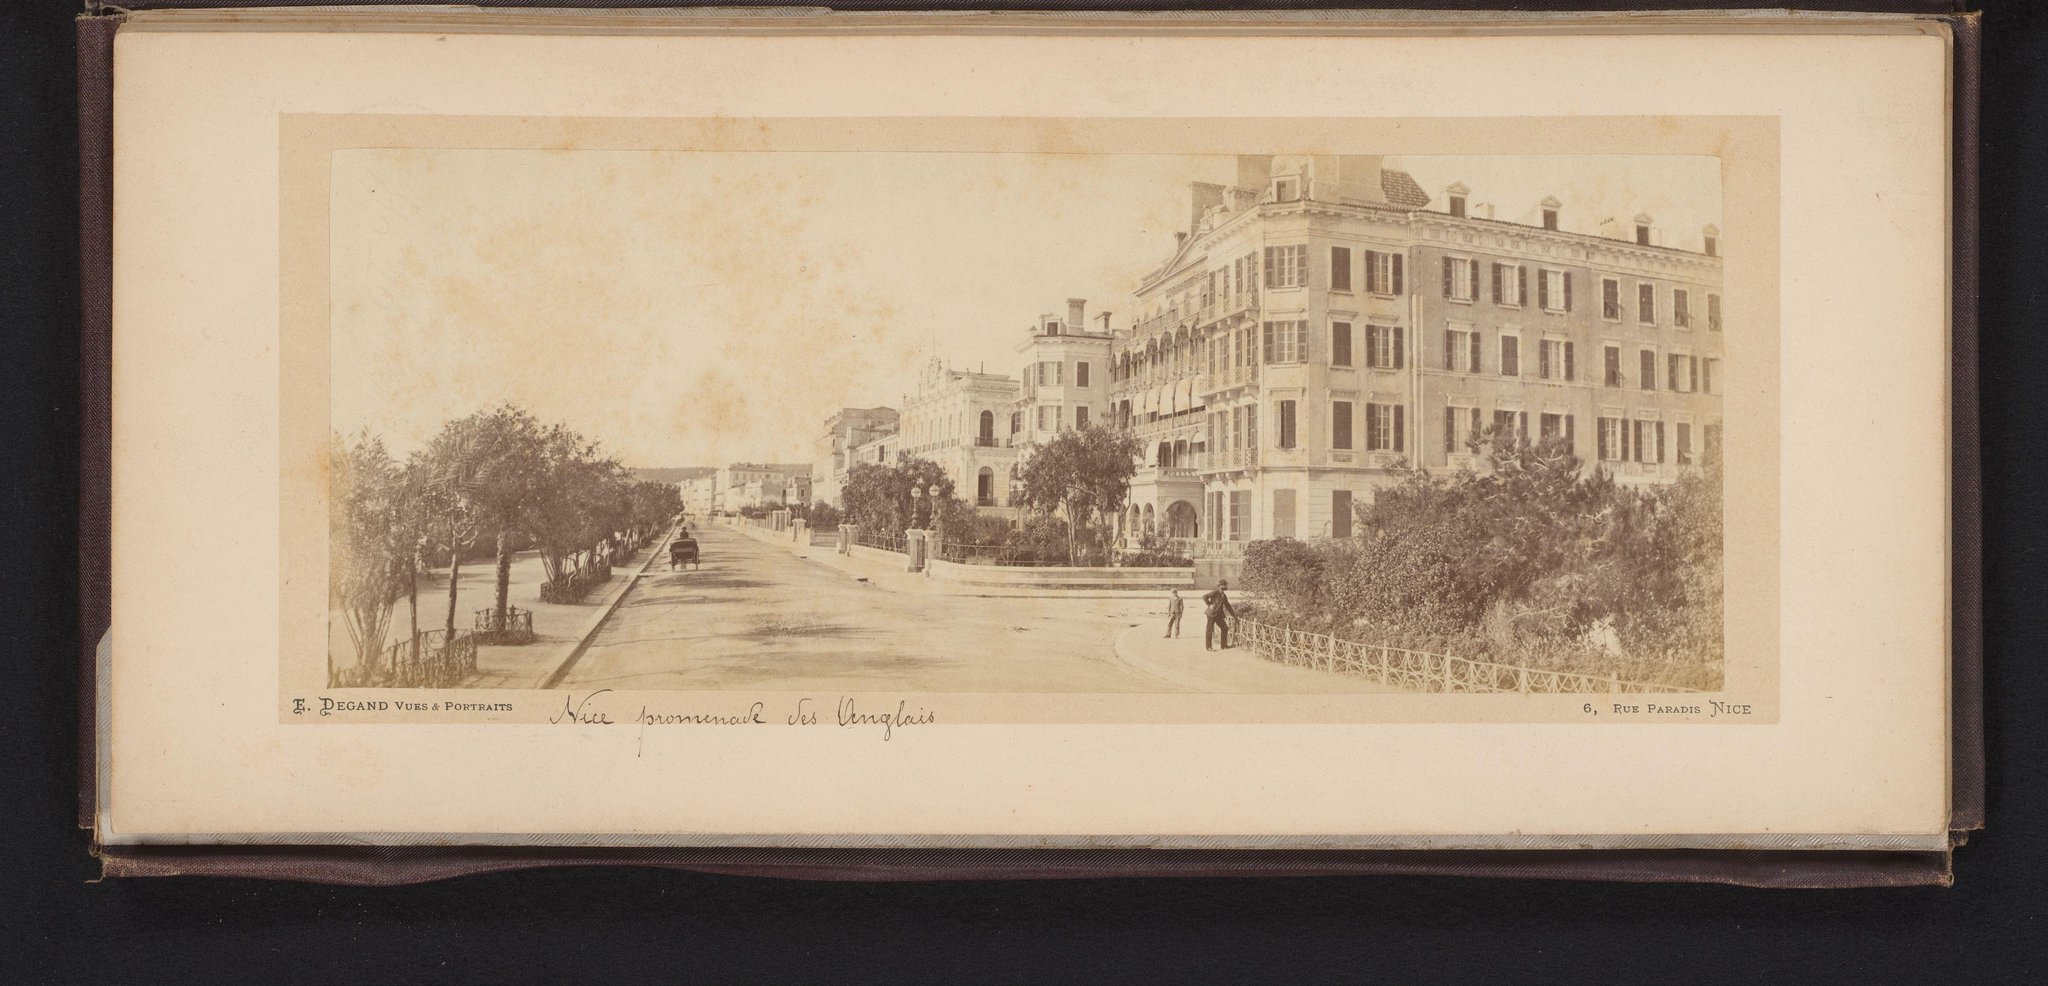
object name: blad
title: Gezicht op Promenade des Anglais te Nice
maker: eugène degand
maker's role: painter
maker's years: 1829-1911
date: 1872-1874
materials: cardboard, photographic support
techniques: albumen print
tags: trees, street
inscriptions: inscription: ‘E. Degand Vues&Portraits 6, Rue Paradis Nice’, annotation: ‘Nice, promenade des Anglais’